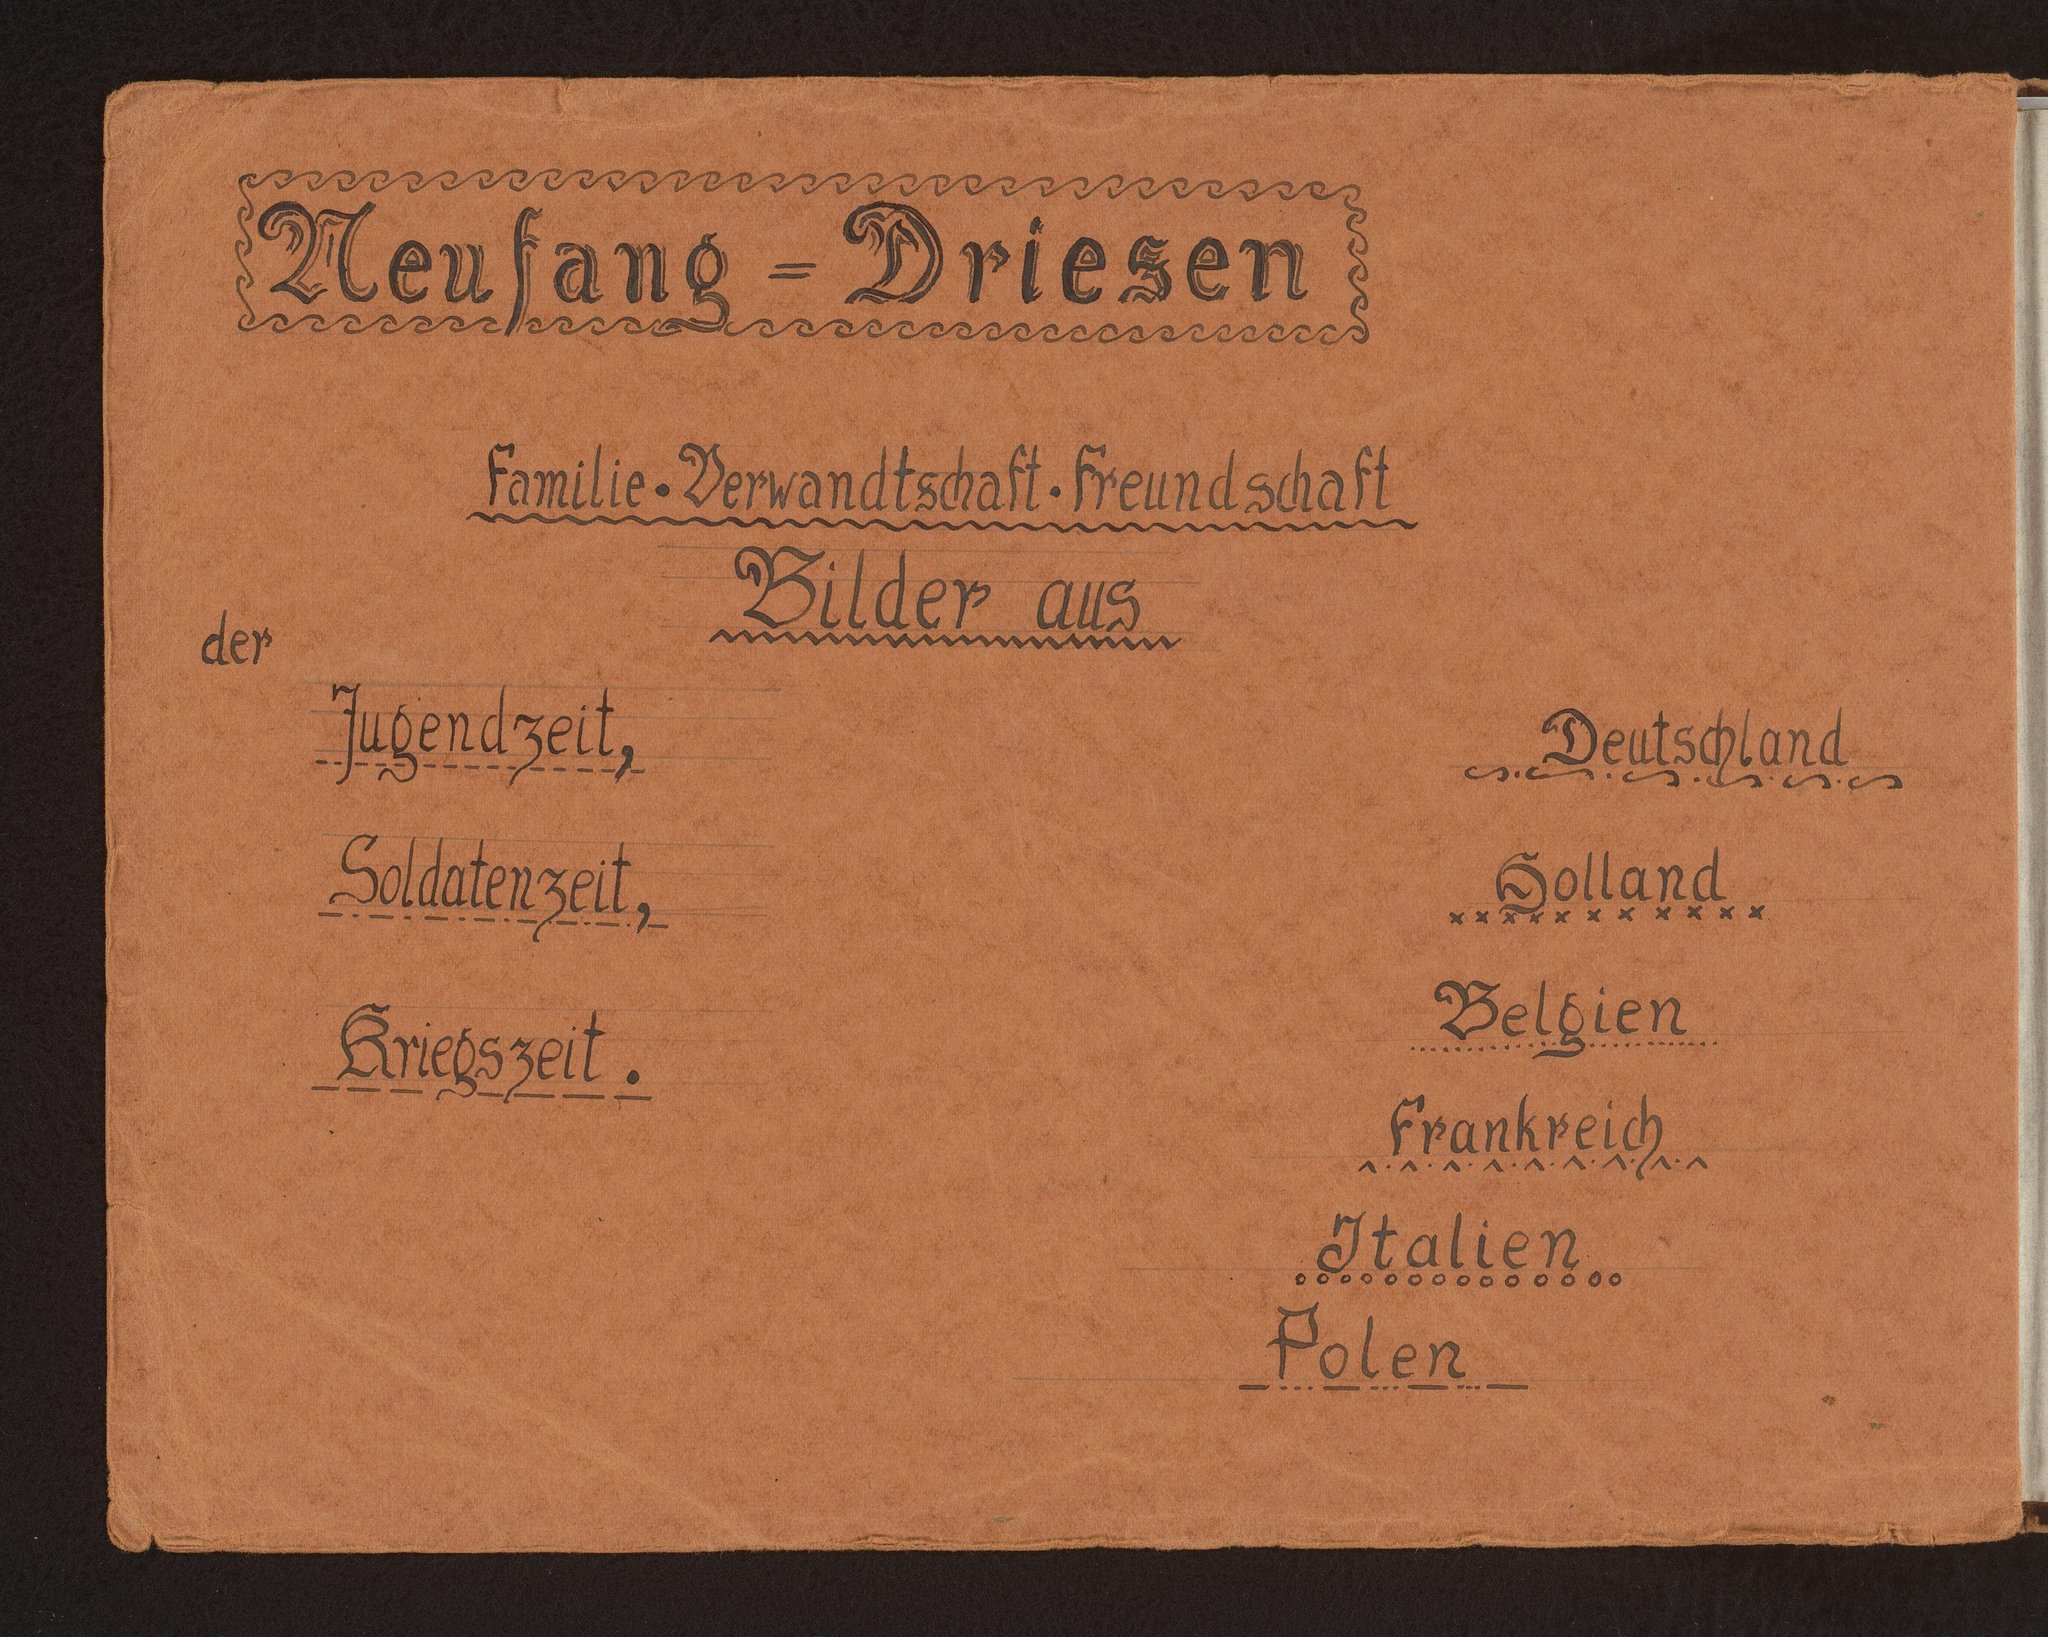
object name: album leaf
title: Neufang -Driesen / Familie - Verwandtschaft - Freundschaft / Bilder aus der Jugendzeit, Soldatenzeit, Kriegszeit, Deutschland, Holland, Belgien, Frankreich, Italien, Polen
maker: werner neufang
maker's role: militair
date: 1940-1945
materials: paper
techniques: writing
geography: germany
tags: kriegsmarine, tweede wereldoorlog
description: Schutblad met overzicht van de inhoud van het fotoalbum. Onderdeel van een fotoalbum over de Duitse Werner Neufang van de Kriegsmarine en de Nederlandse Thea Driesen.